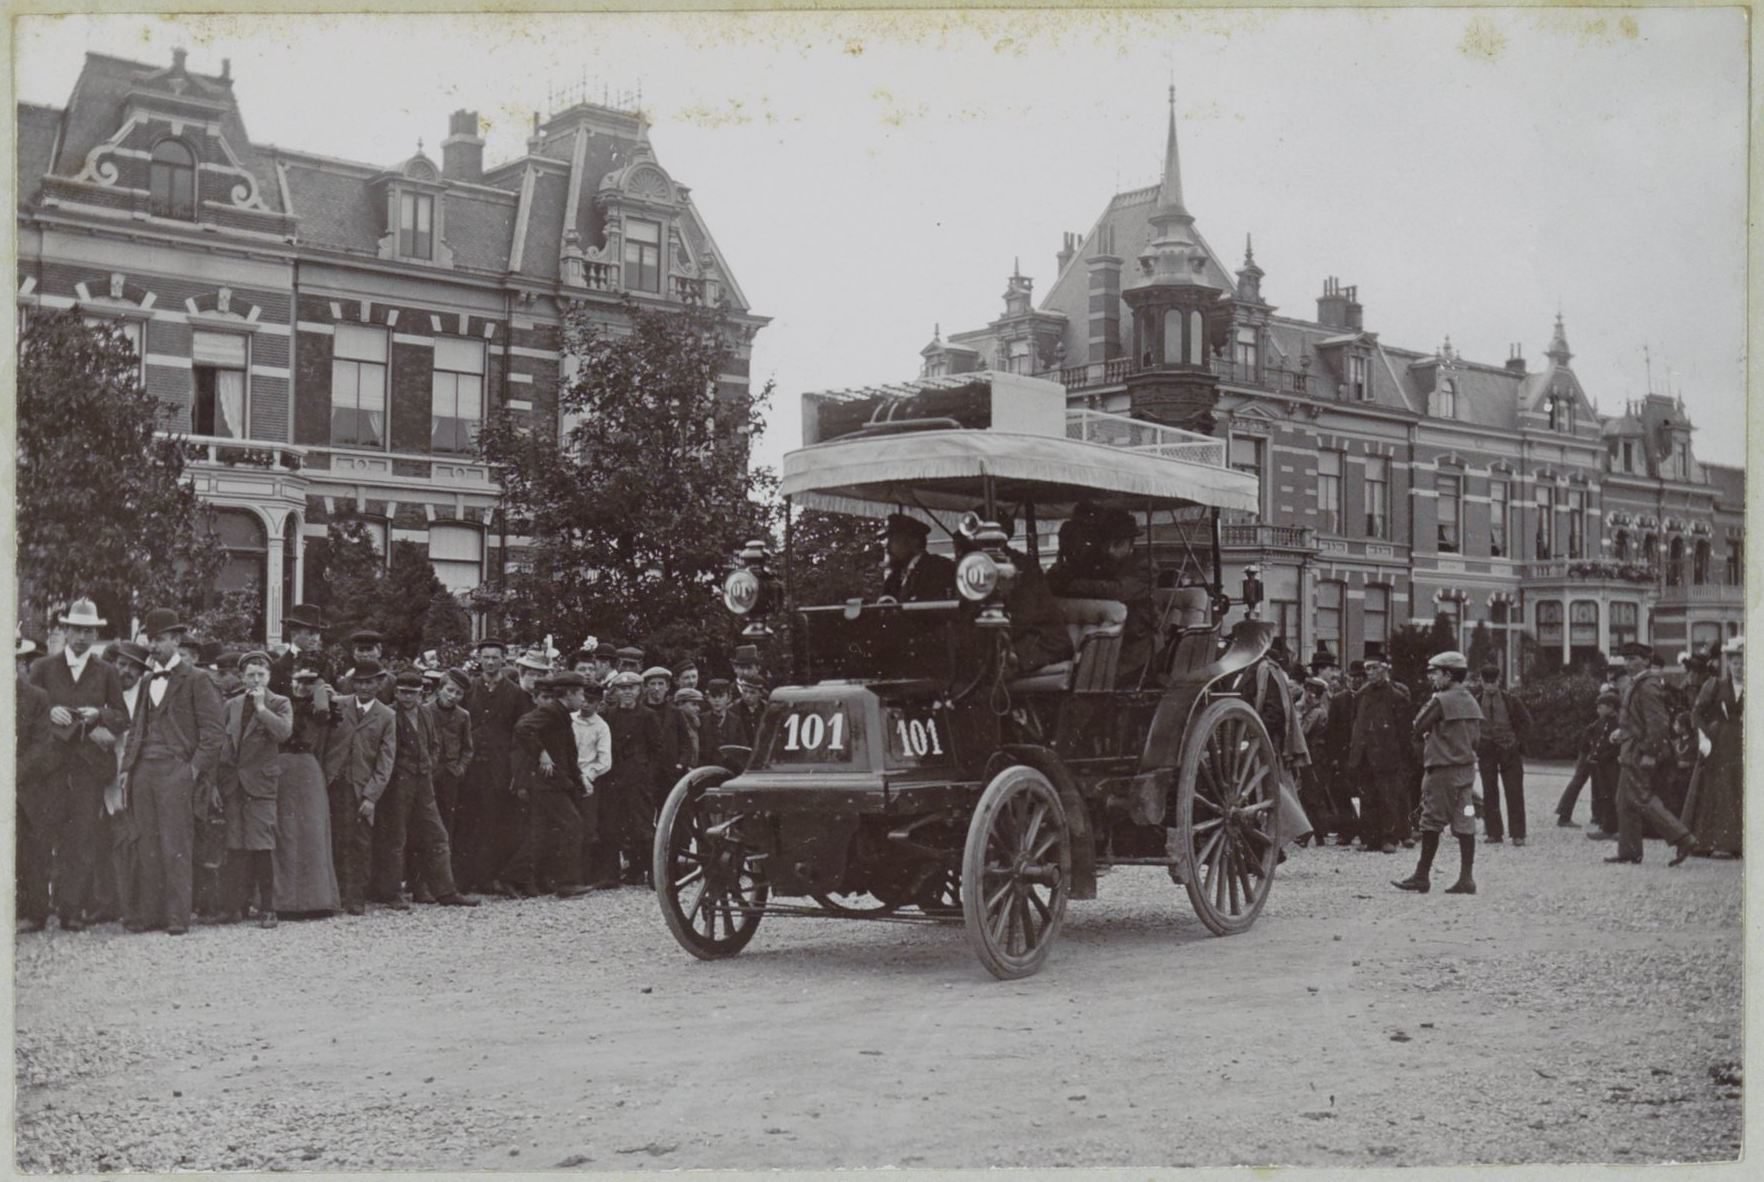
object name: photograph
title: Autocoureur Prevost (Prevot), deelnemer aan de race Parijs-Amsterdam, in zijn automobiel (vermoedelijk) te Nijmegen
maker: delizy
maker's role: manufacturer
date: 1807-1898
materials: paper, photographic support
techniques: collodion silver print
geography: nijmegen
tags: motorcar racing, automobile, nijmegen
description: Onderdeel van Fotoalbum van een Franse amateurfotograaf met opnames van uitstapjes in Frankrijk, Spanje, België, Luxemburg en Nederland, de eerste automobielen en autoraces.